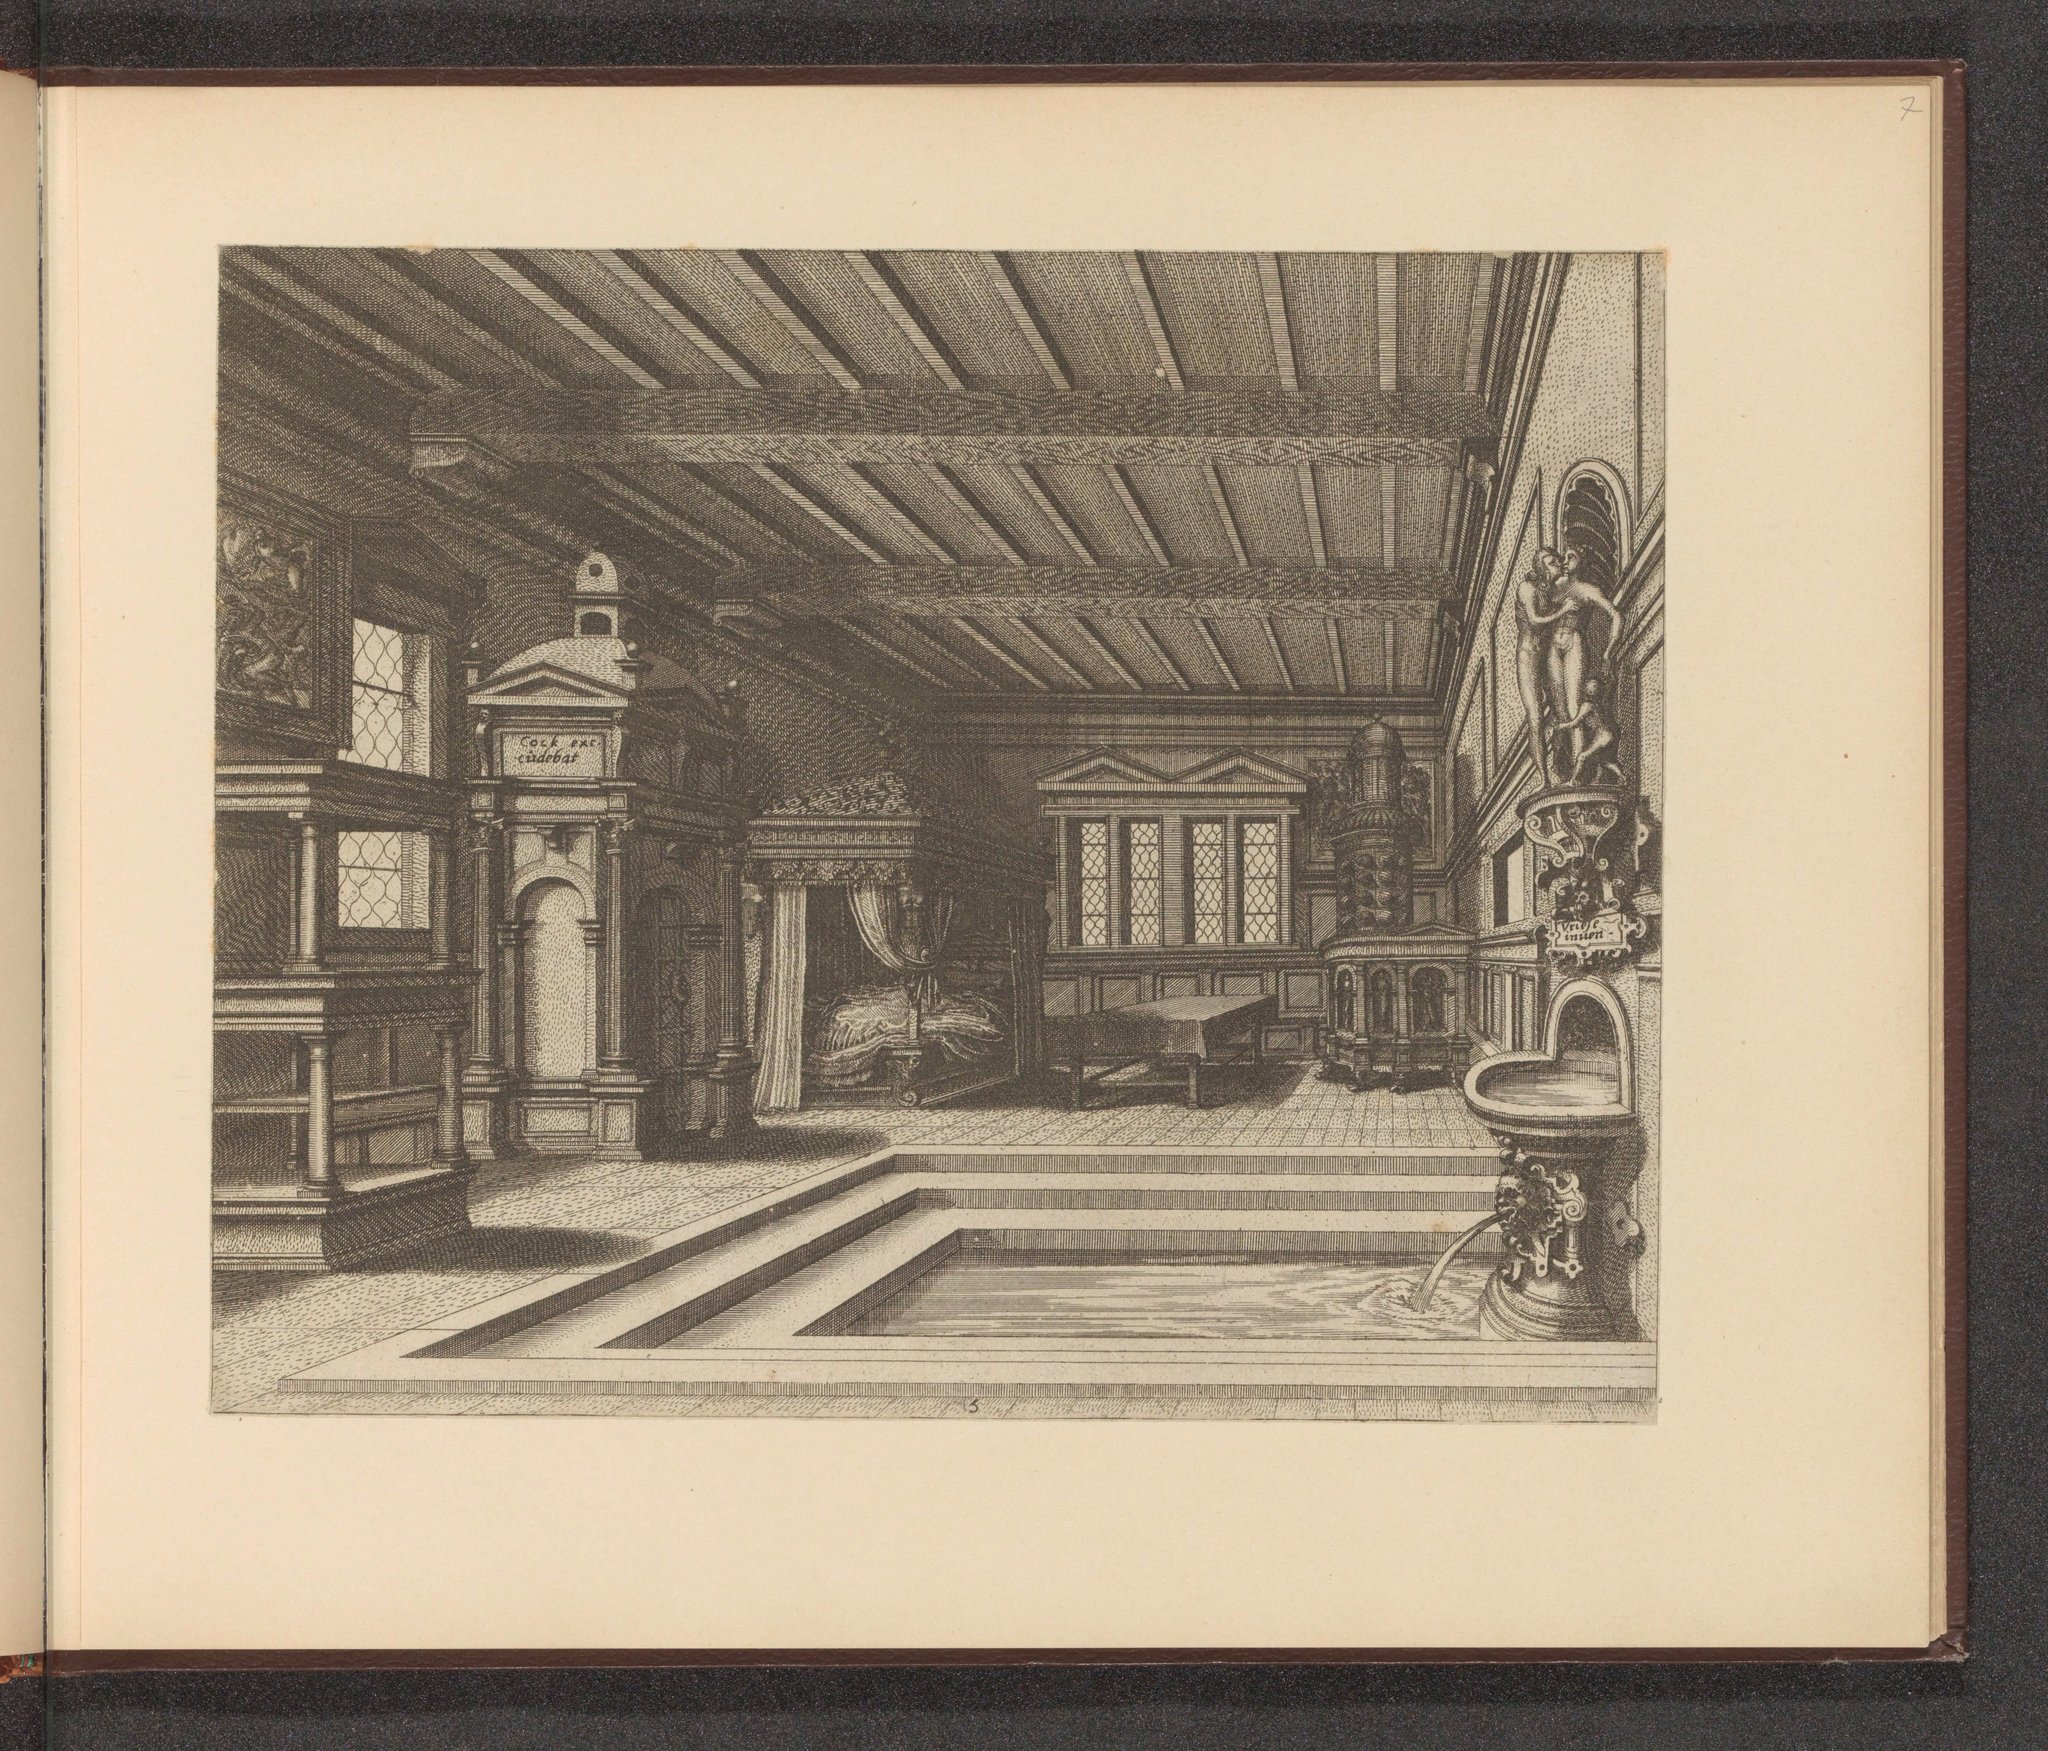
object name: print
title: Interieur met bed en waterbassin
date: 1563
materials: paper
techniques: etching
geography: antwerp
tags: jug and basin; wash-basin, bed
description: Interieur met een bed met baldakijn in de hoek en op de voorgrond een waterbassin met fontein. Boven de fontein een beeld van een minnekozend paar. Prent maakt deel uit van een album.